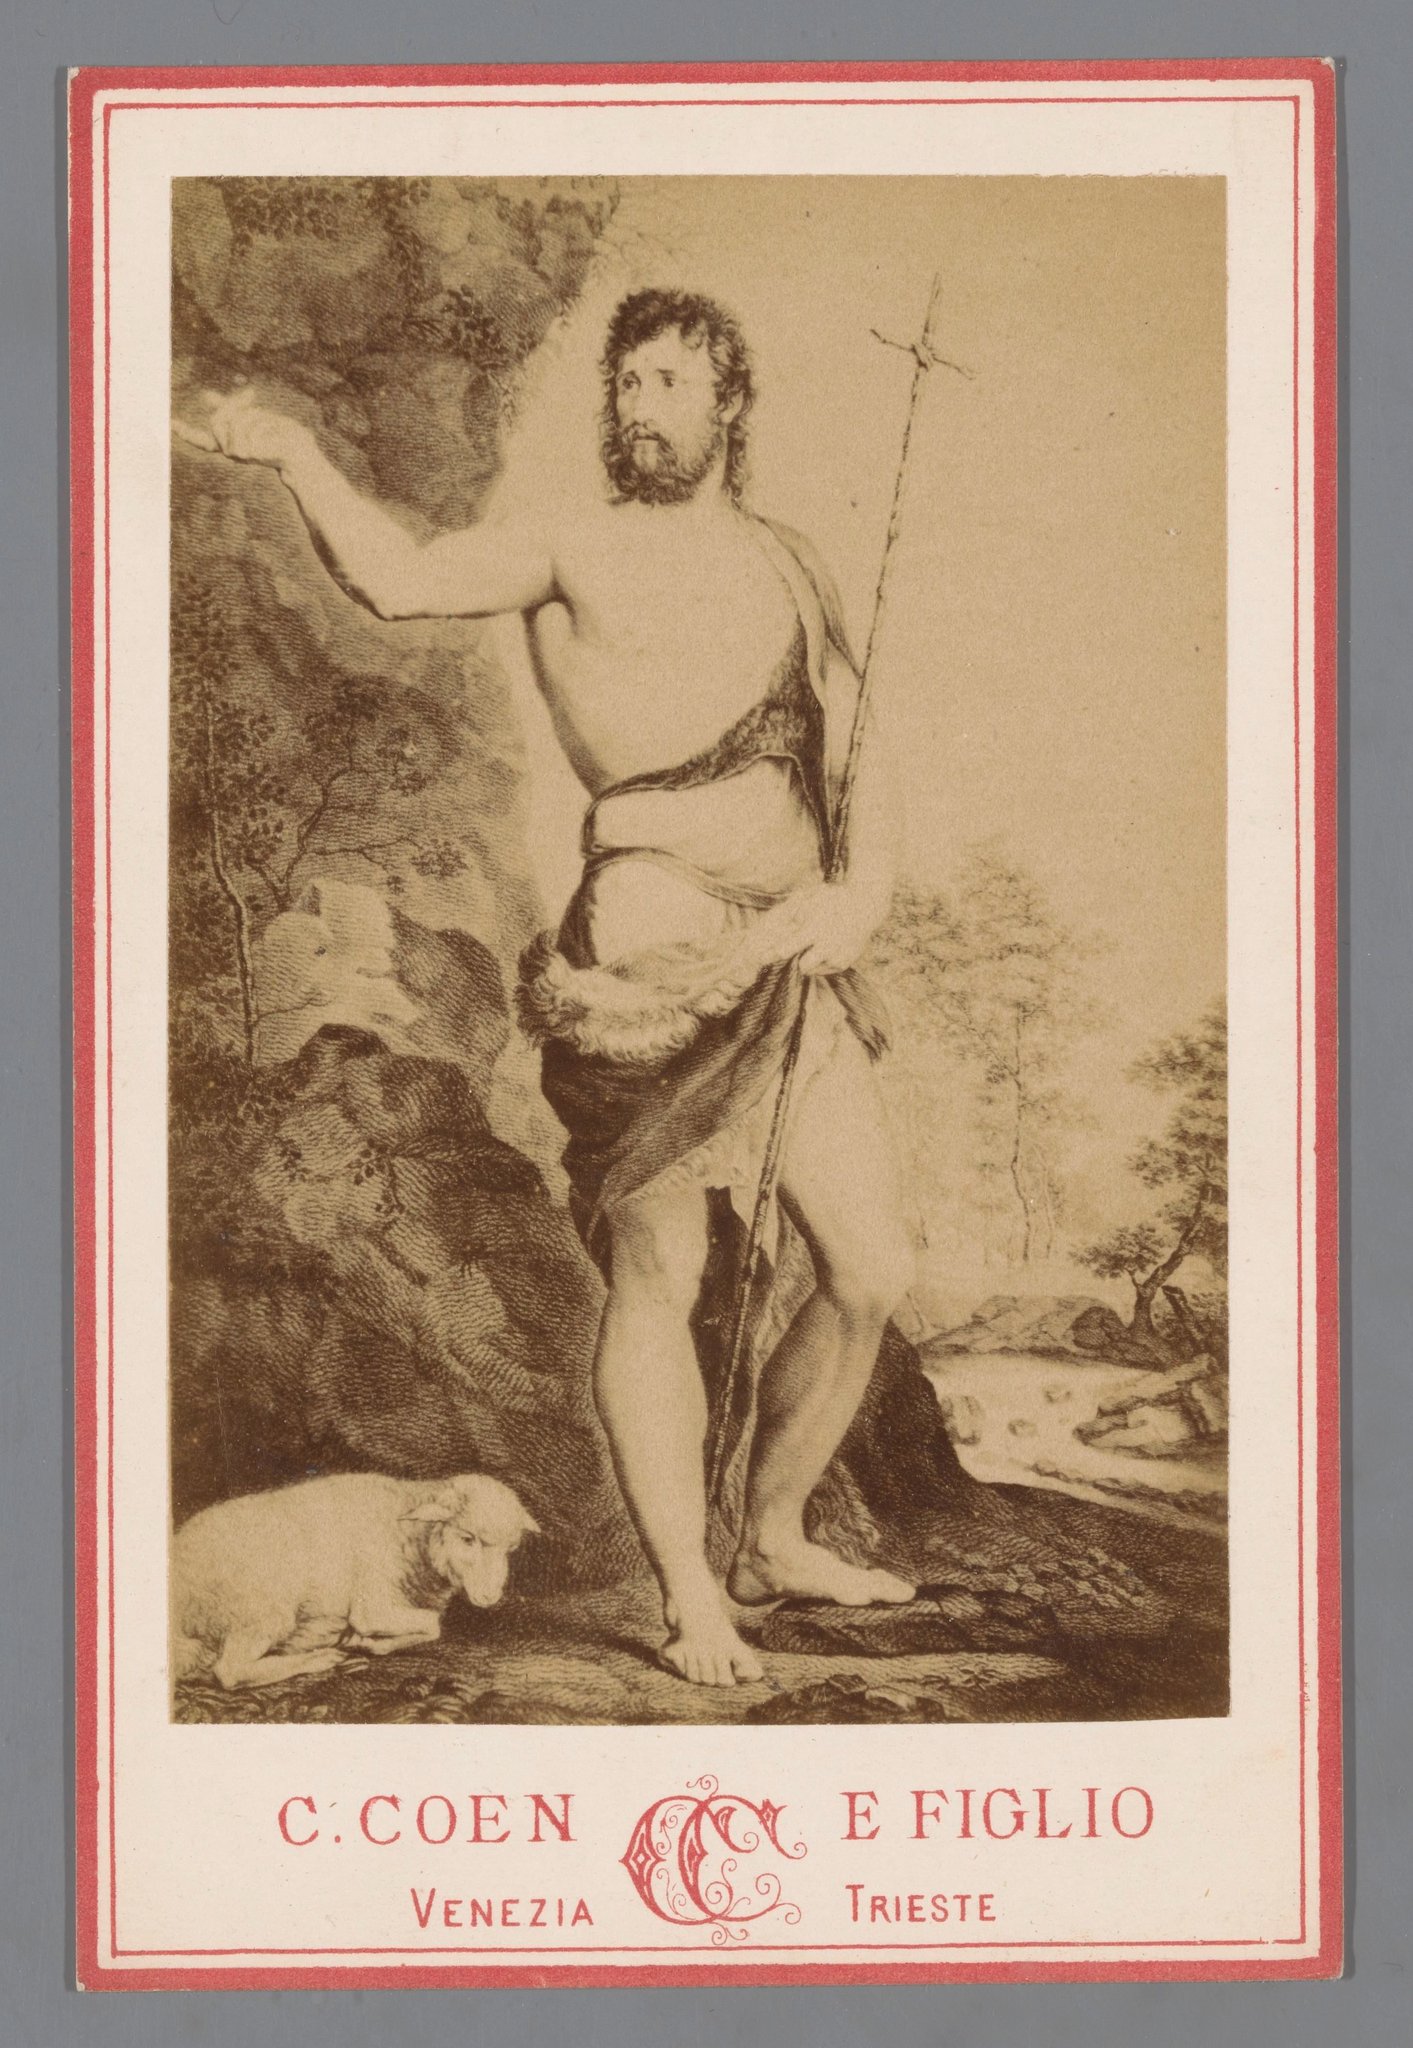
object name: cabinet photograph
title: Fotoreproductie van een tekening naar een schilderij van Johannes de Doper door Titiaan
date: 1870-1900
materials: cardboard, photographic support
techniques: albumen print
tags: series of scenes from the life of john the baptist, picture, painting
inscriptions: inscription: ‘25 40 4 s. Giovanni B - Tizian’